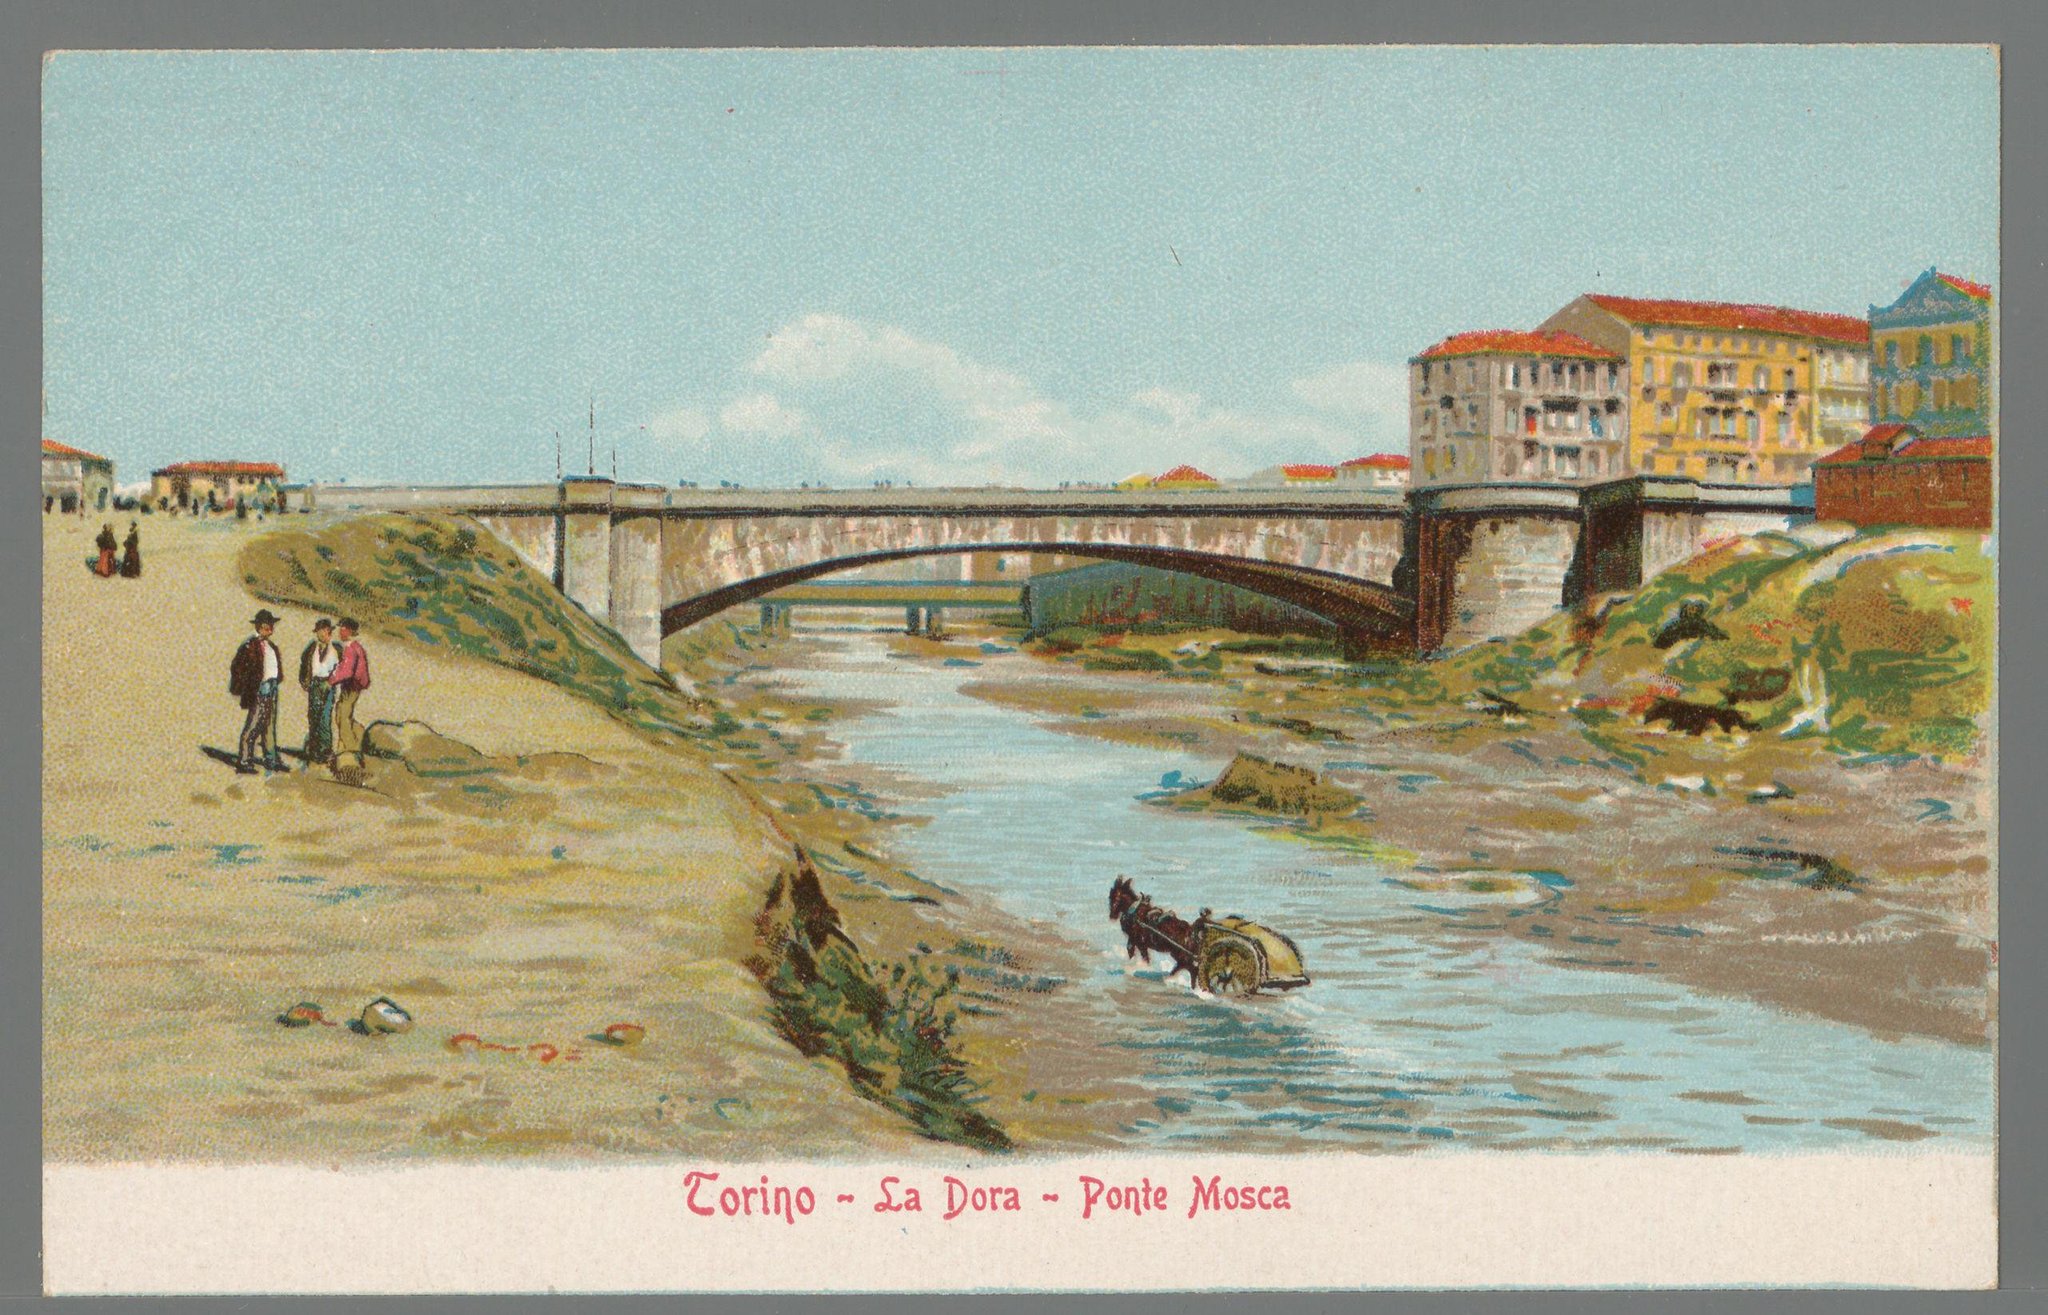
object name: print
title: Torino. La Dora. Ponte Mosca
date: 1906-1920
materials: cardboard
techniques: lithograph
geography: venice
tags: river, bridge, city-view, and landscape with man-made constructions (+ city(-scape) with figures, staffage)